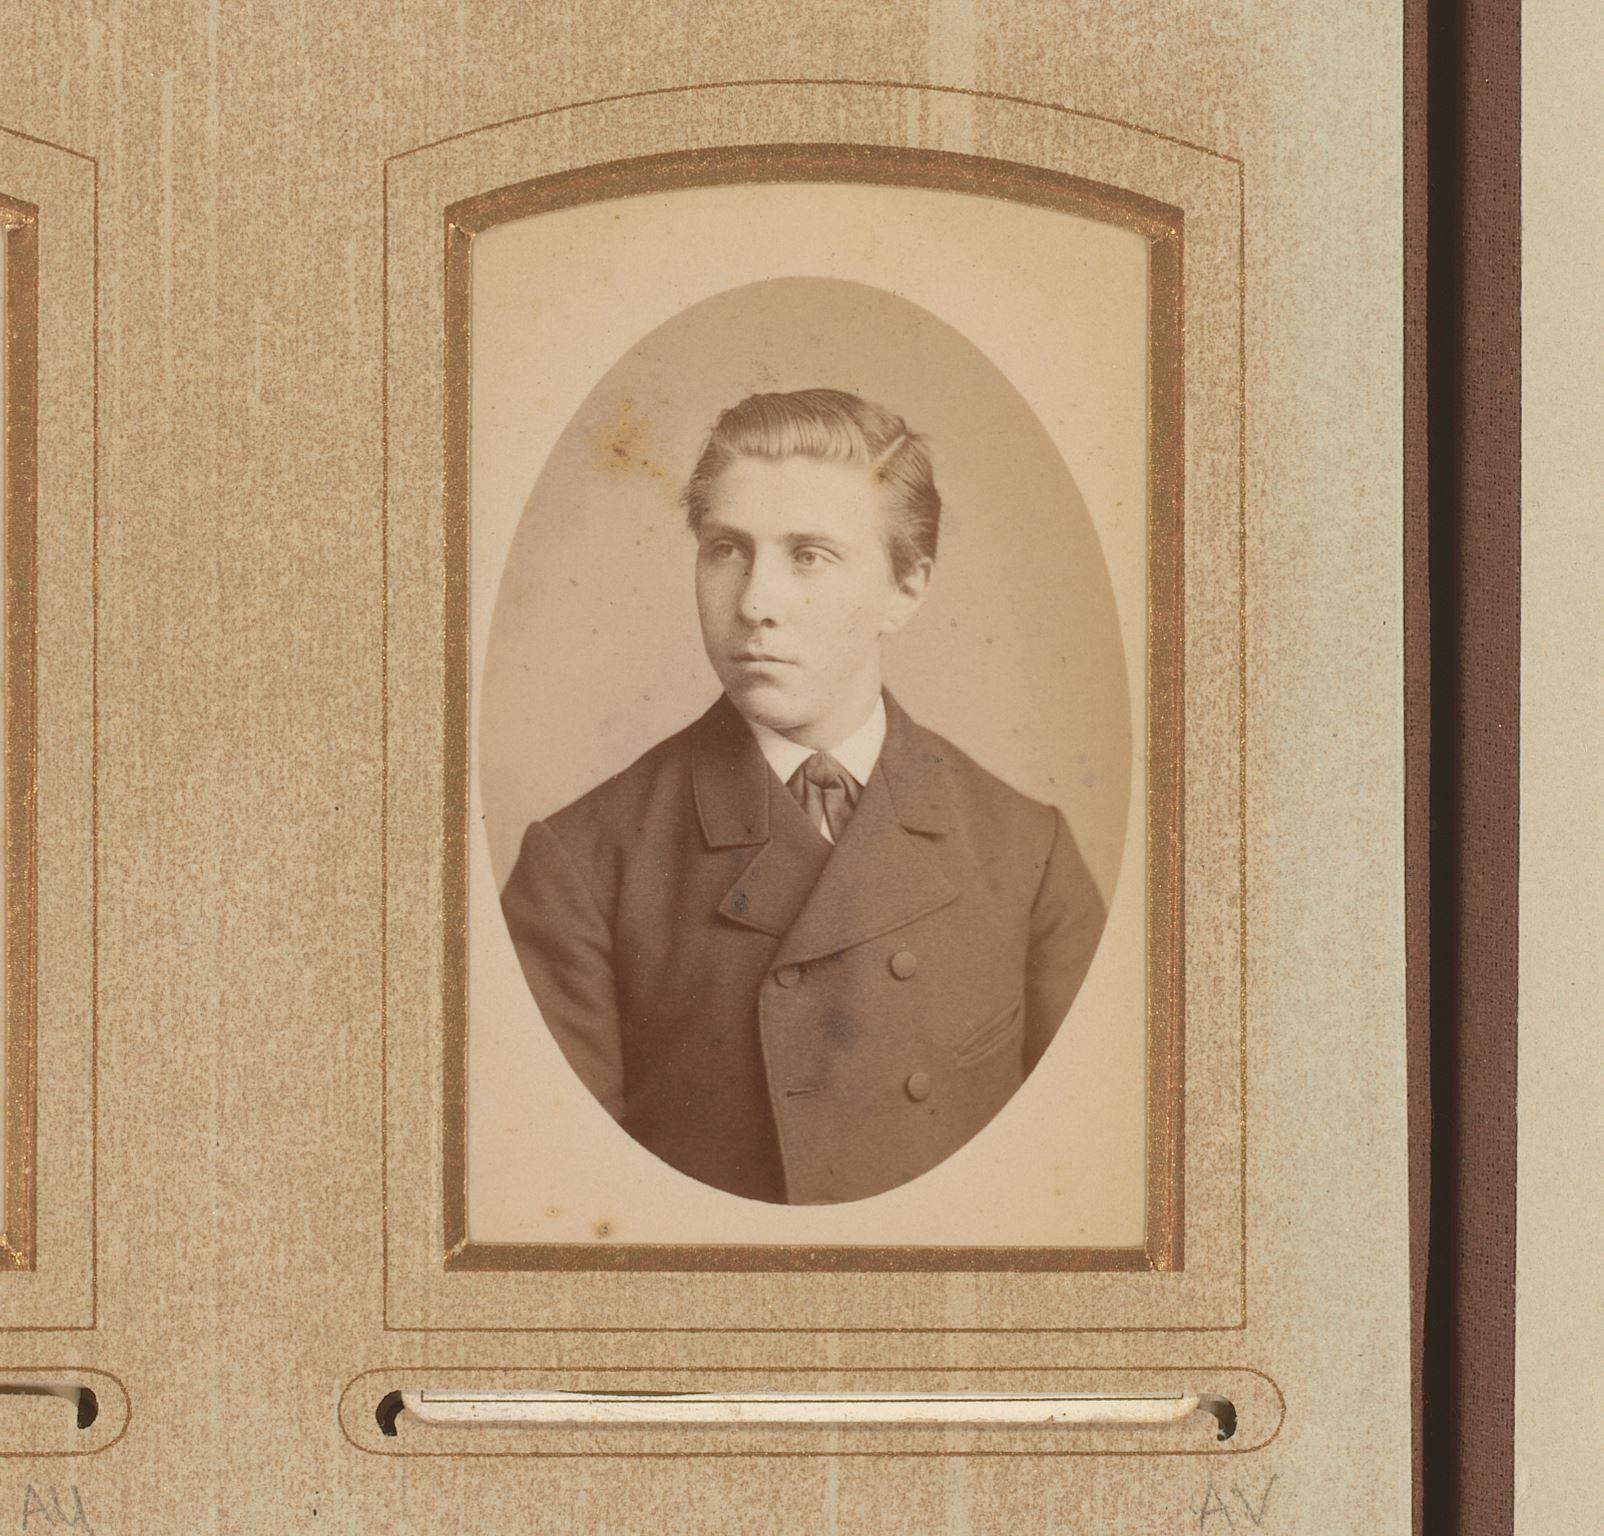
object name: album leaf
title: Portret van een jonge man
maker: wilhelm ivens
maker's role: fotograaf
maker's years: 1849-1904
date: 1881-1887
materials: cardboard, photographic support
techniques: albumen print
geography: nijmegen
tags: historical persons, youth, adolescent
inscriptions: inscription: ‘Wilh. Ivens/ PHOTOGRAAF/ NYMEGEN/ 50, Houtstraat 50/ over de Bloemerstraat./ De plaat blijft voor nabestelling bewaard.’, annotation: ‘Reinder M[ag?]/geb. Garijp/ [.as] Arnhem’